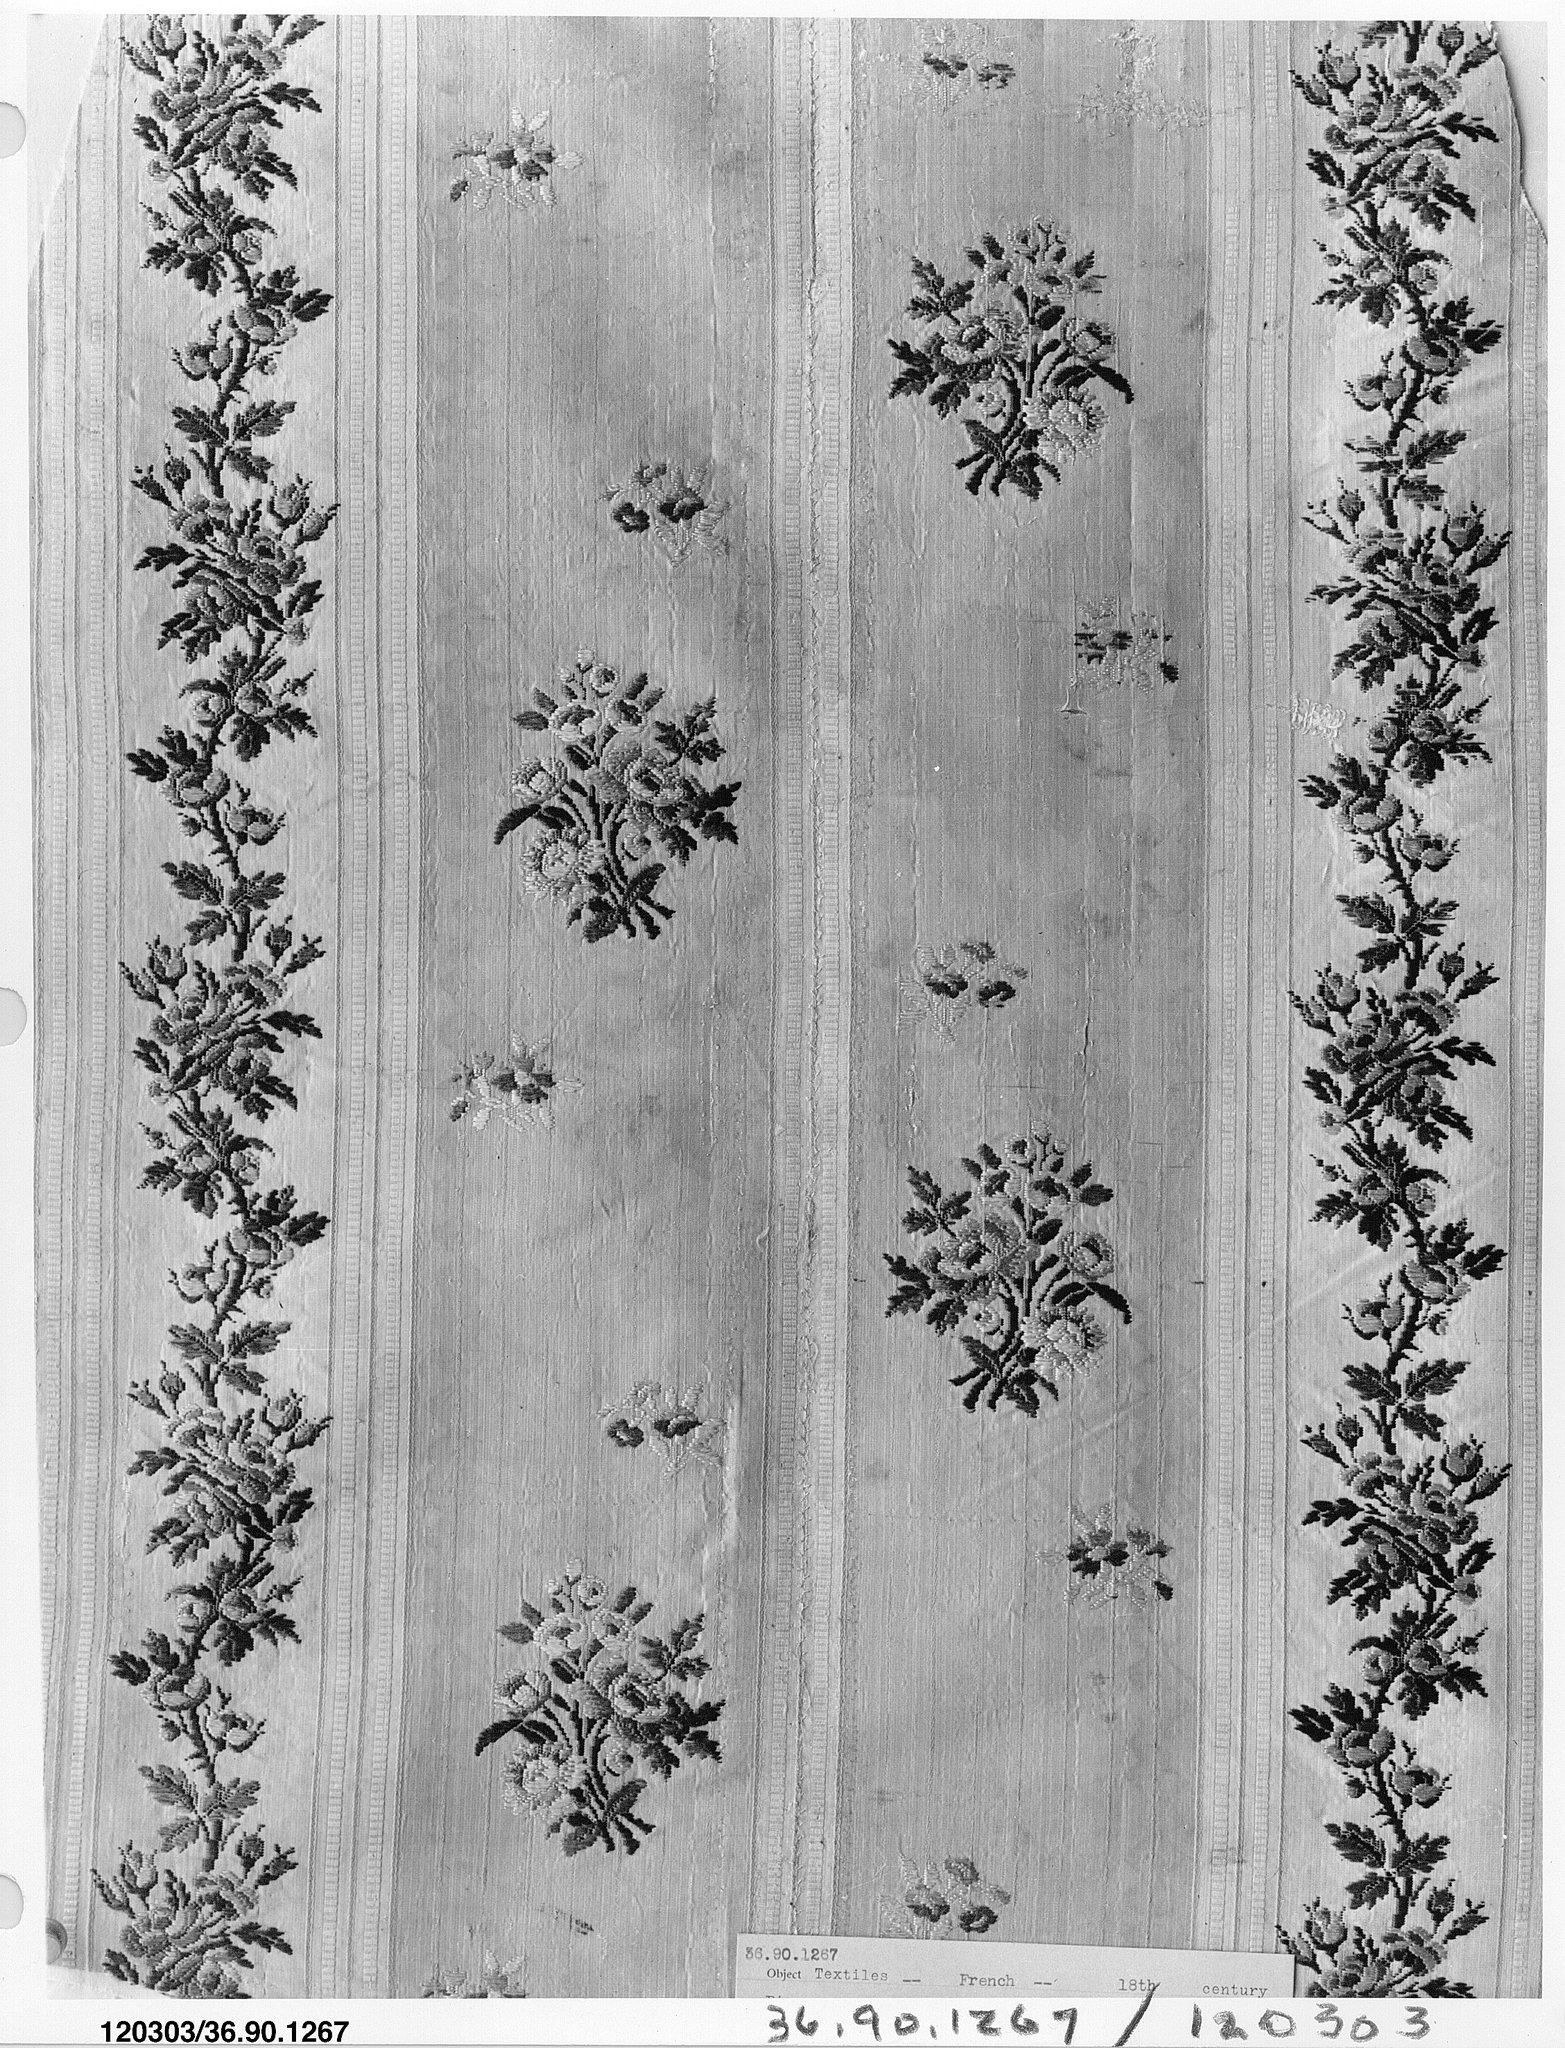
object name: piece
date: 1701-1800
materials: silk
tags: flowers,leaves